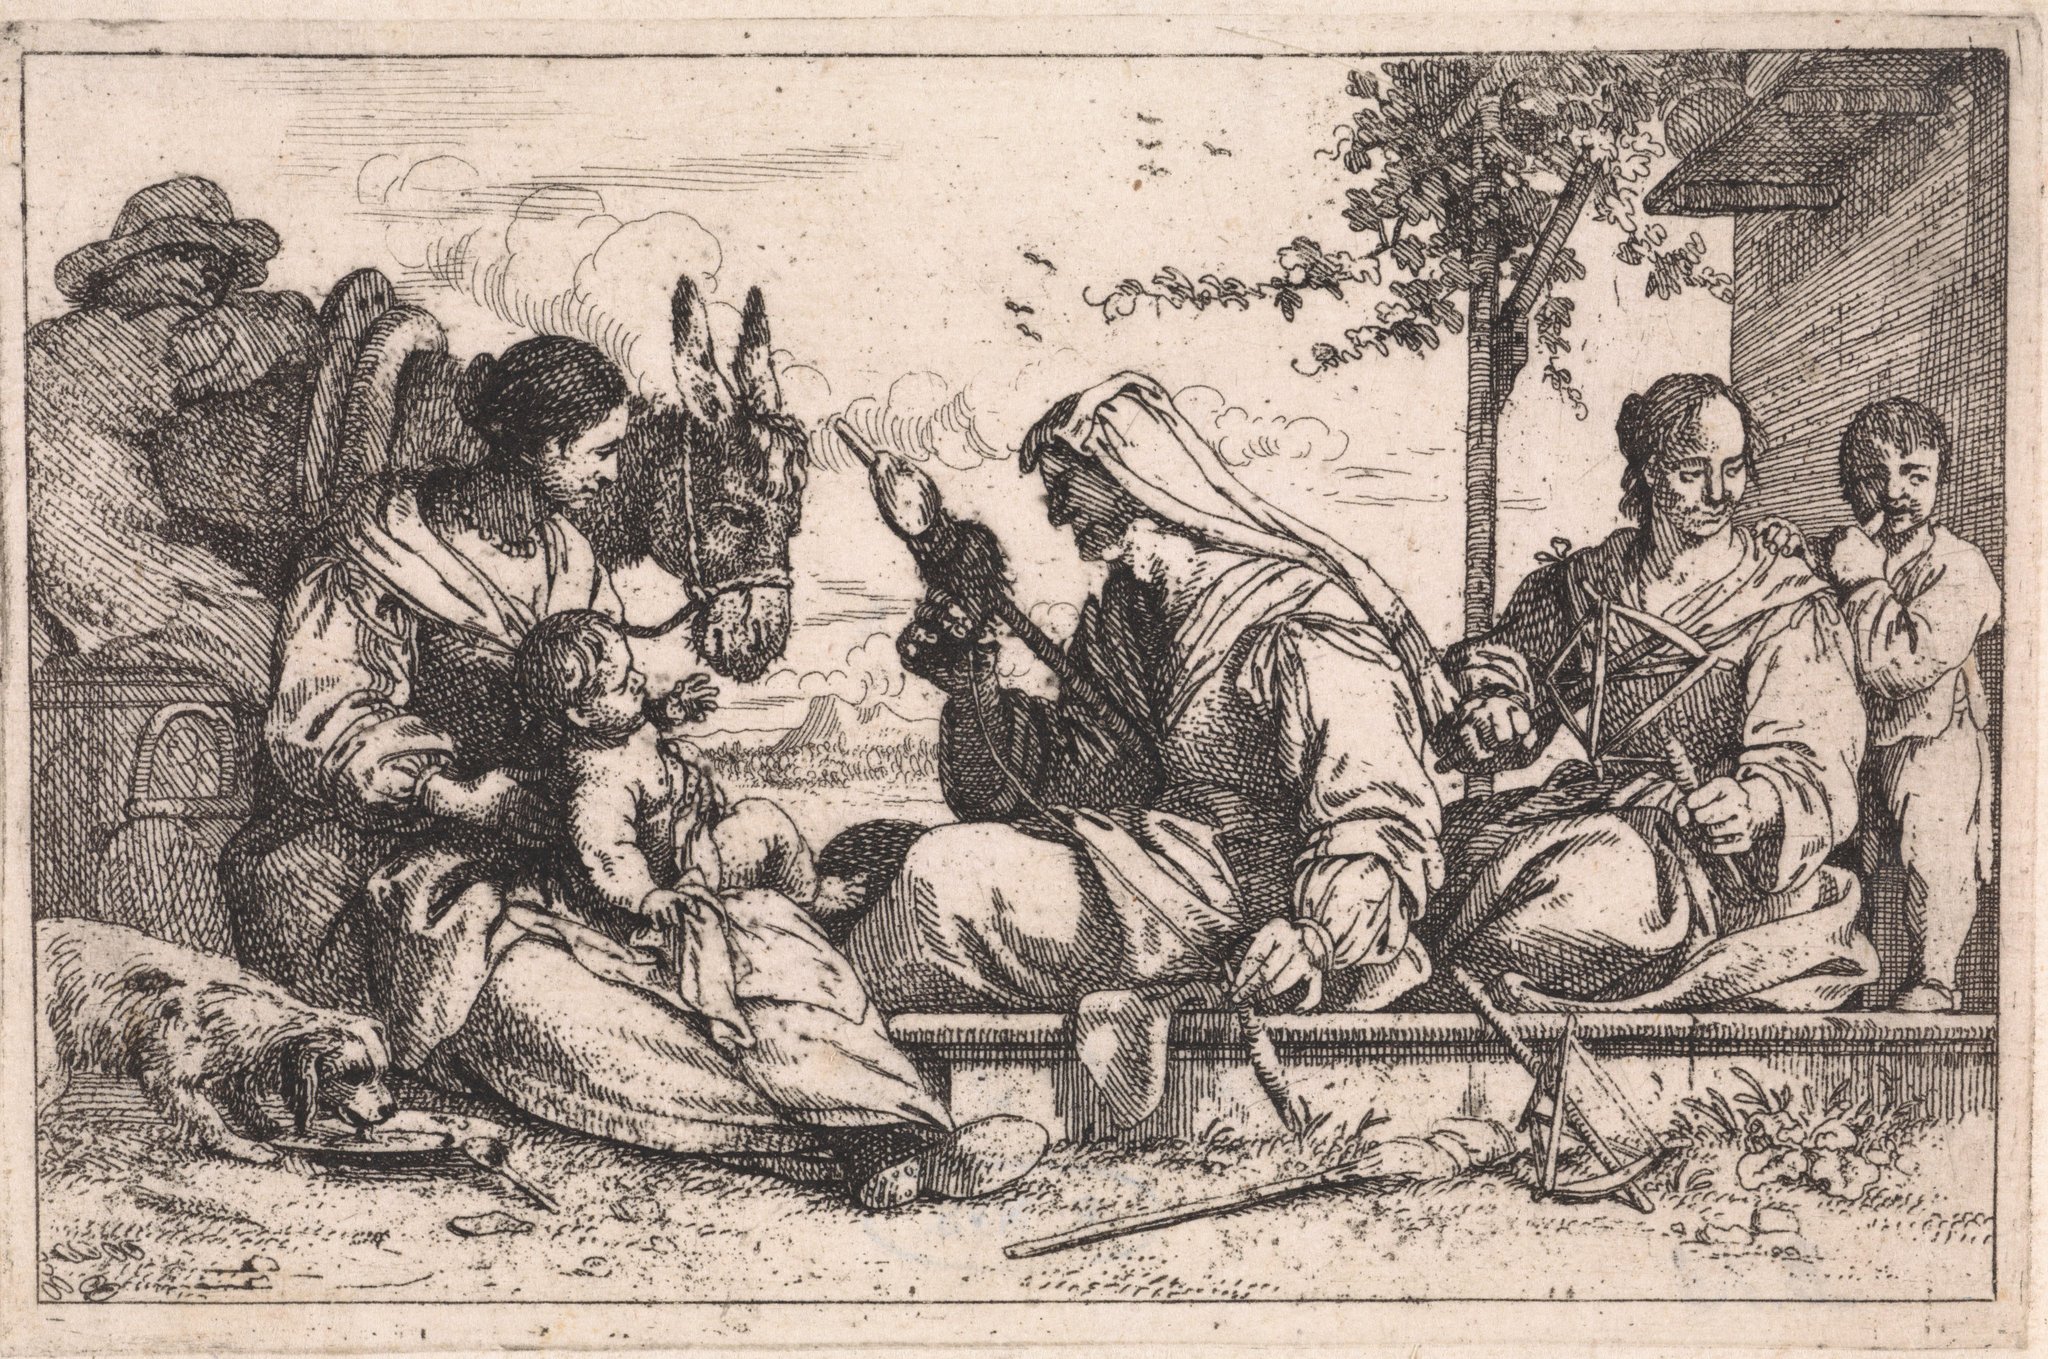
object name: print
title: Diverse genretaferelen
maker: jan baptist de wael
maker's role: print maker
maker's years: 1632-1669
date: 1642-1669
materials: paper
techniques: etching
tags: mother and baby or young child, spinning (manufacture of yarn)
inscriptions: collector's mark: Lugt 2228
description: Een vrouw is aan het spinnen voor een huis. Ze wordt vergezeld door twee vrouwen met kinderen. Links een man die op de rug van zijn ezel leunt.